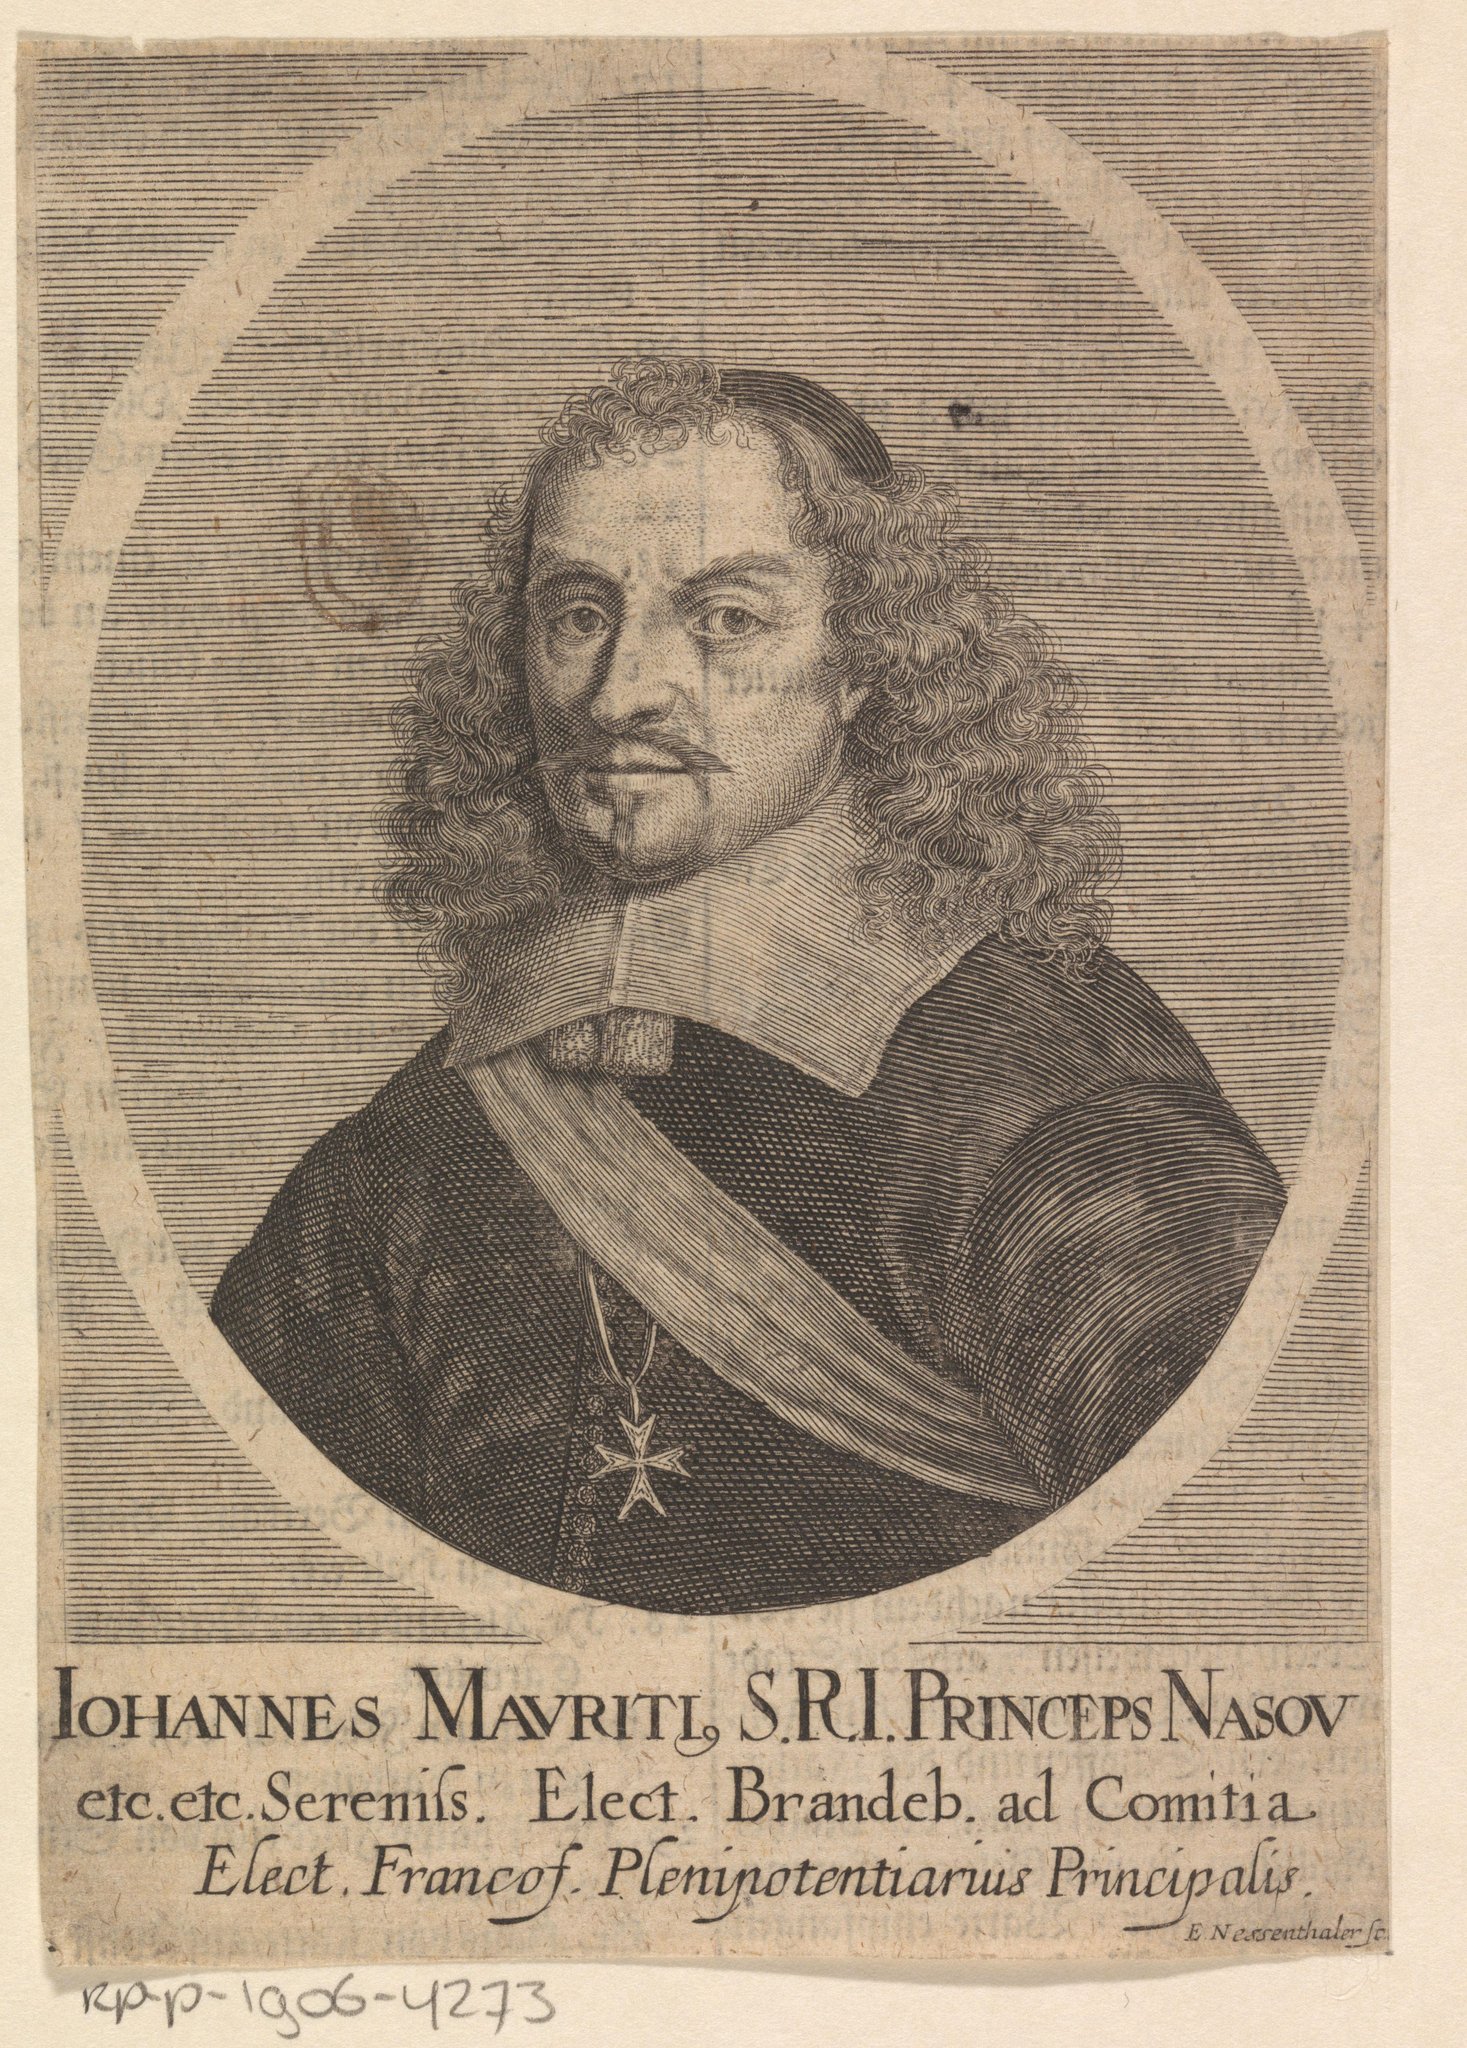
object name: book illustration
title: Portret van Johan Maurits, graaf van Nassau-Siegen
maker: elias nessenthaler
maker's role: print maker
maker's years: 1664-1714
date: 1674-1714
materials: paper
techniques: engraving, etching, letterpress printing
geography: germany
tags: earl, johan maurits graaf van nassau-siegen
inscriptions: collector's mark: Lugt 2228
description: De hier vermelde titel verwijst naar de hoogst verkregen titel van de geportretteerde, niet per se naar de titel die de geportretteerde op deze voorstelling draagt.